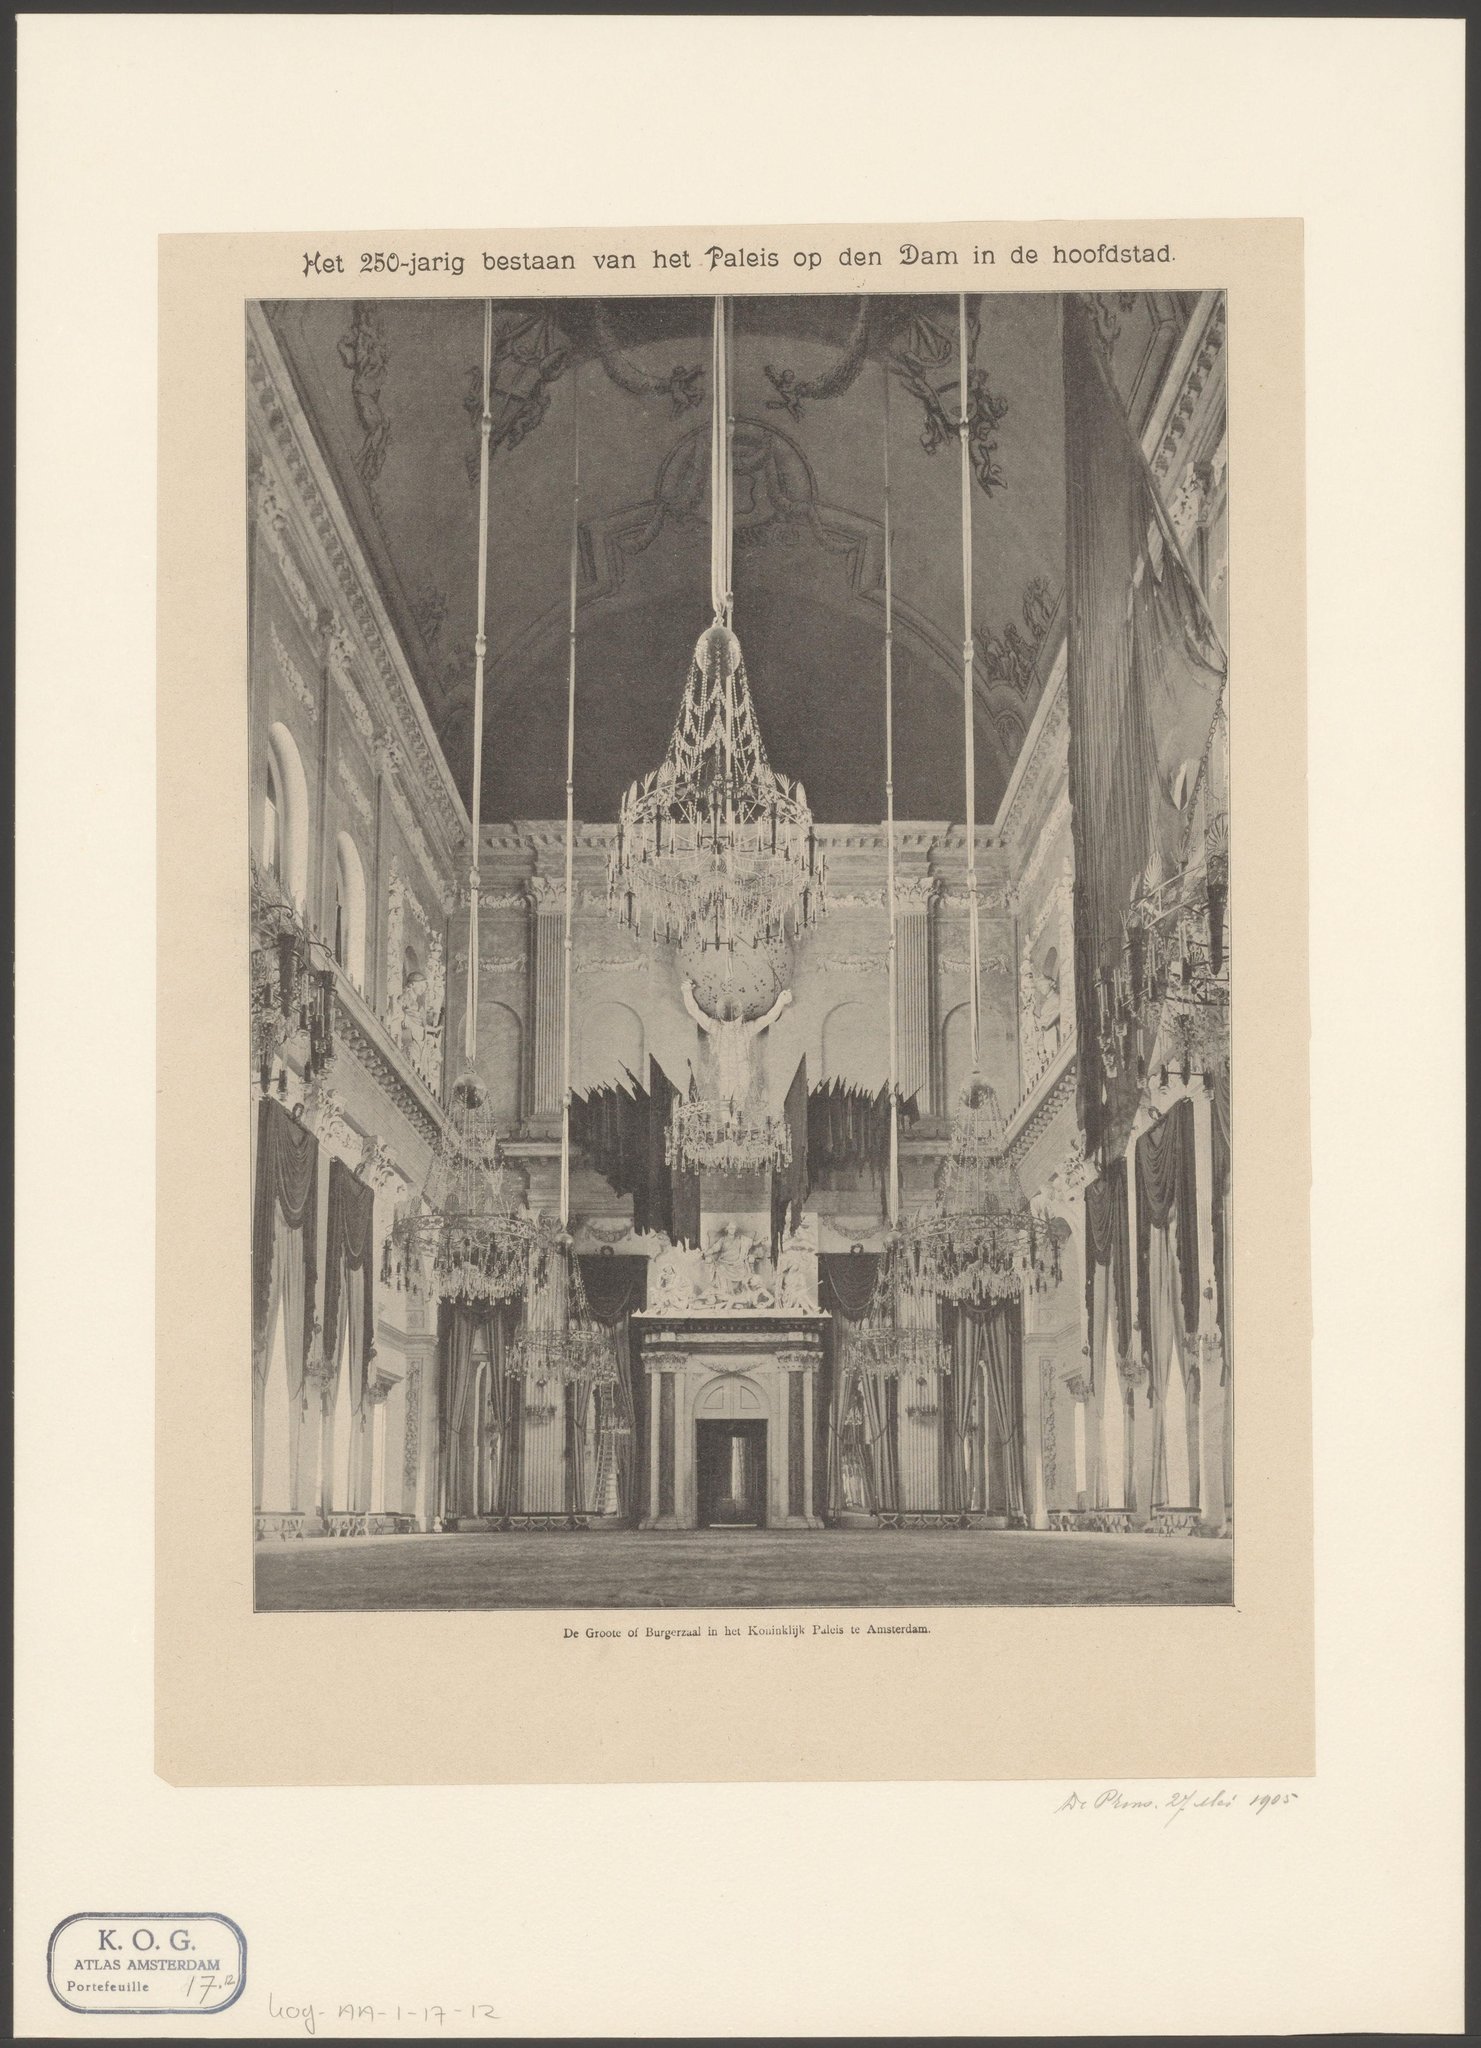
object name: photomechanical print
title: Gezicht op de Burgerzaal in het Paleis op de Dam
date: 1905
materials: paper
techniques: letterpress printing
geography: amsterdam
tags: townhall, royal palace of amsterdam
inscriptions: collector's mark: ‘17.12’ Lugt 1641b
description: Onderwerpsrubriek binnen de Atlas Amsterdam: Nieuwe Stadhuis, van binnen: Groote zaal, Raadkamer, Schepenkamer, Troonzaal, Mozeszaal, Zitkamer.